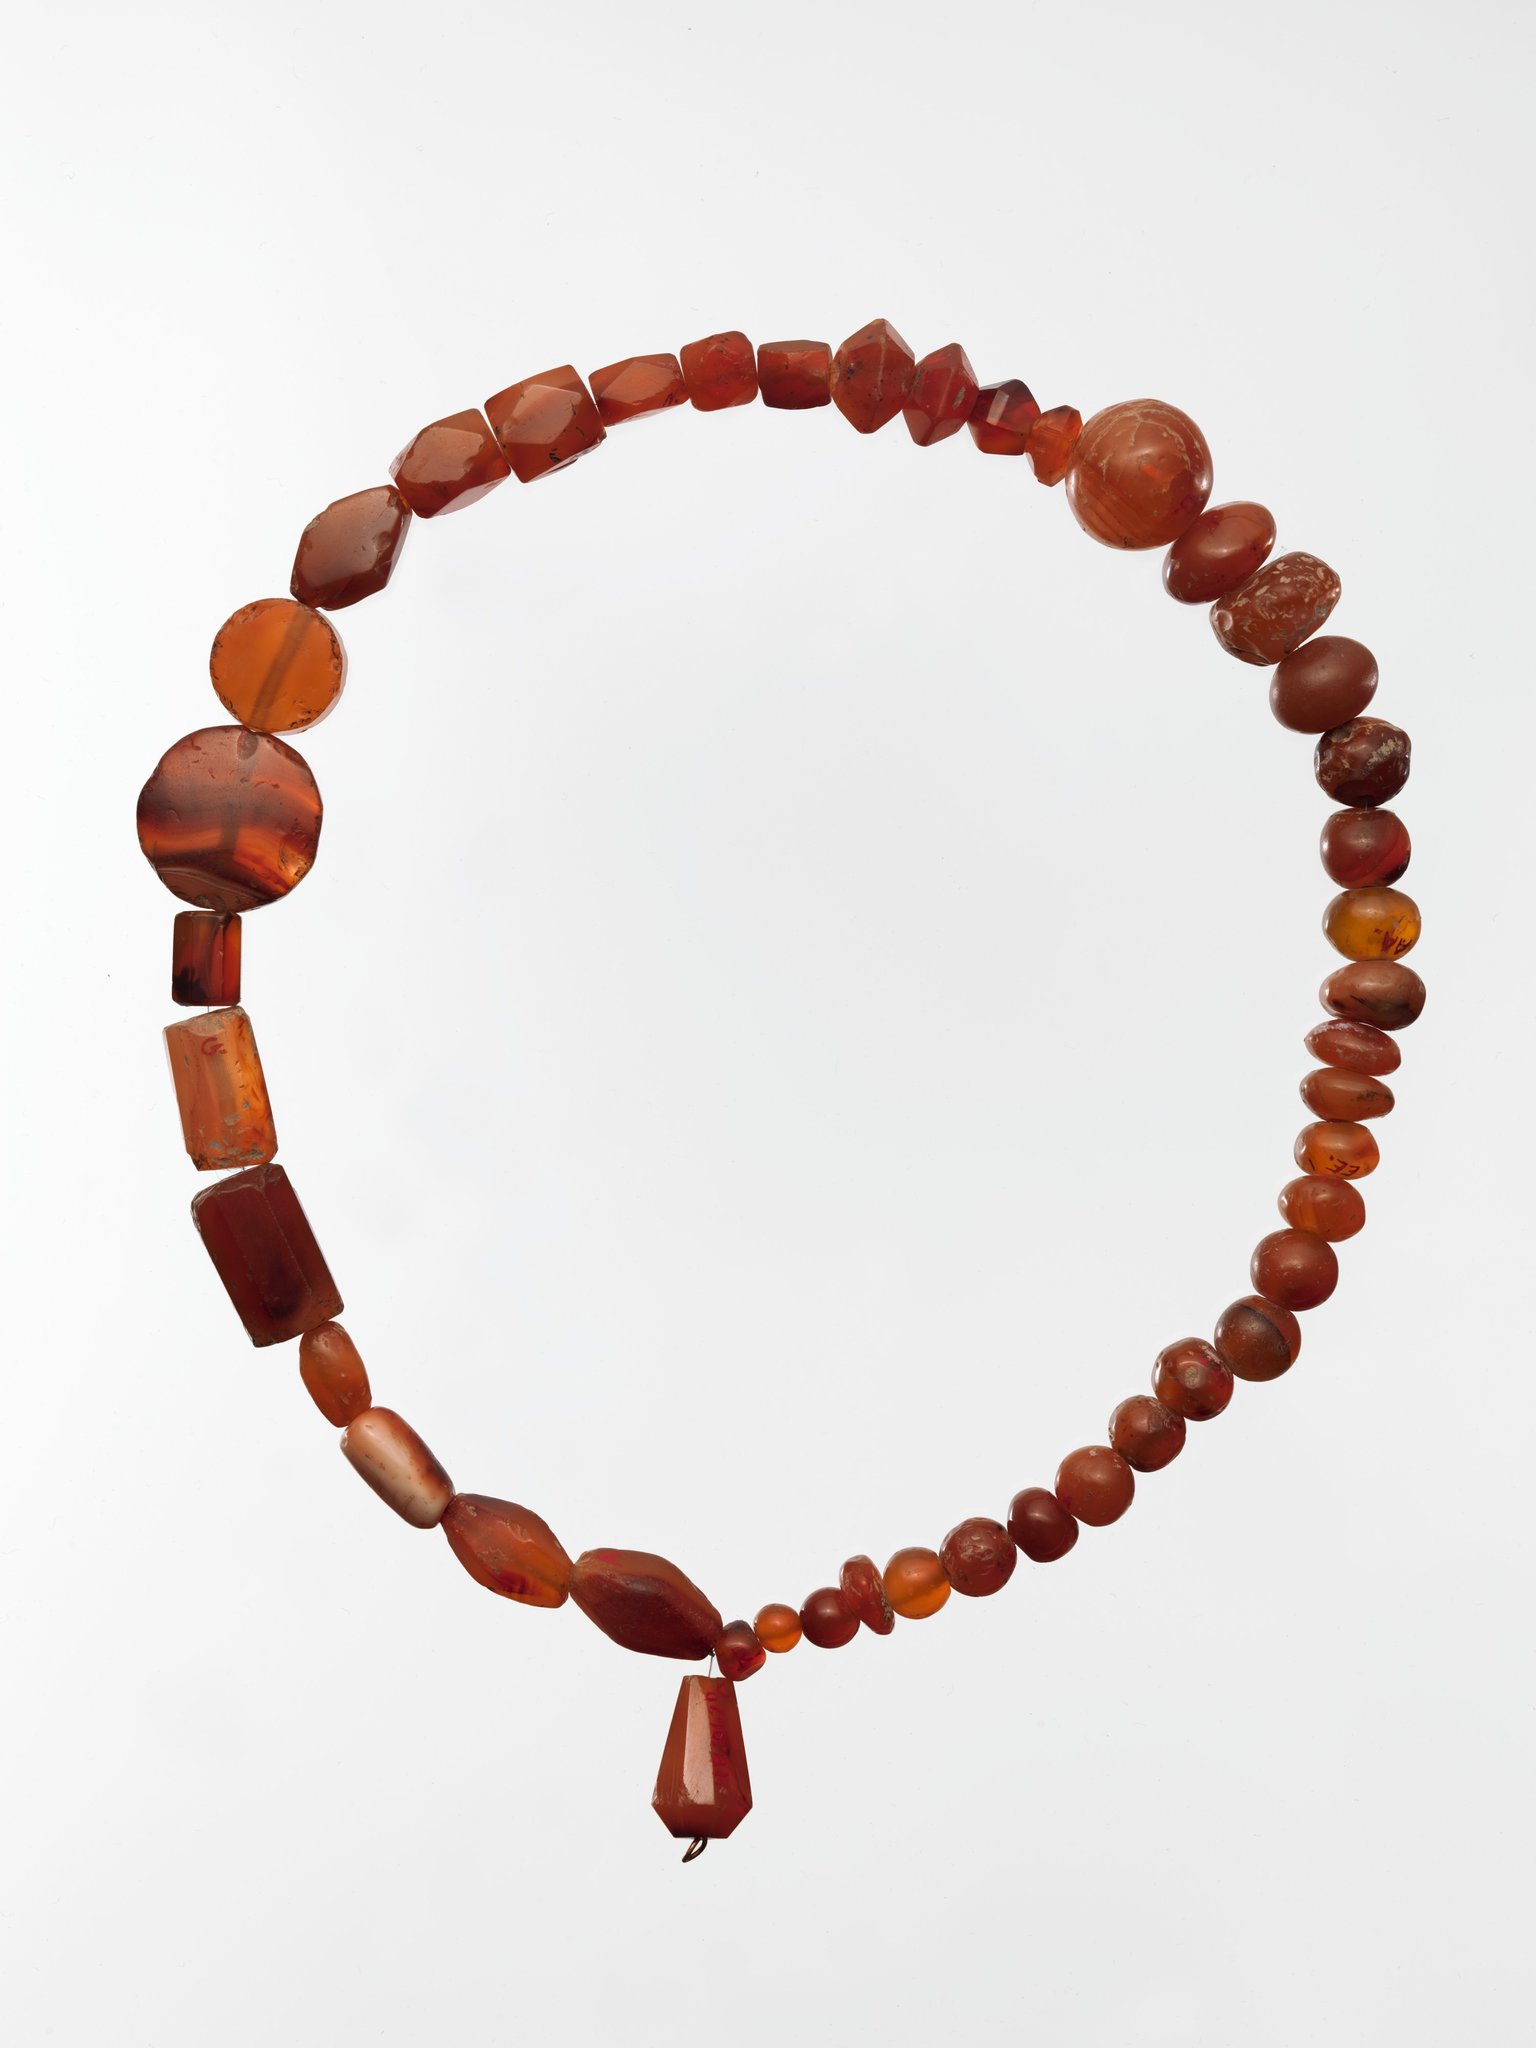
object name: strand of bead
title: Strand of Beads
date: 801-1200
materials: gemstone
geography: iran